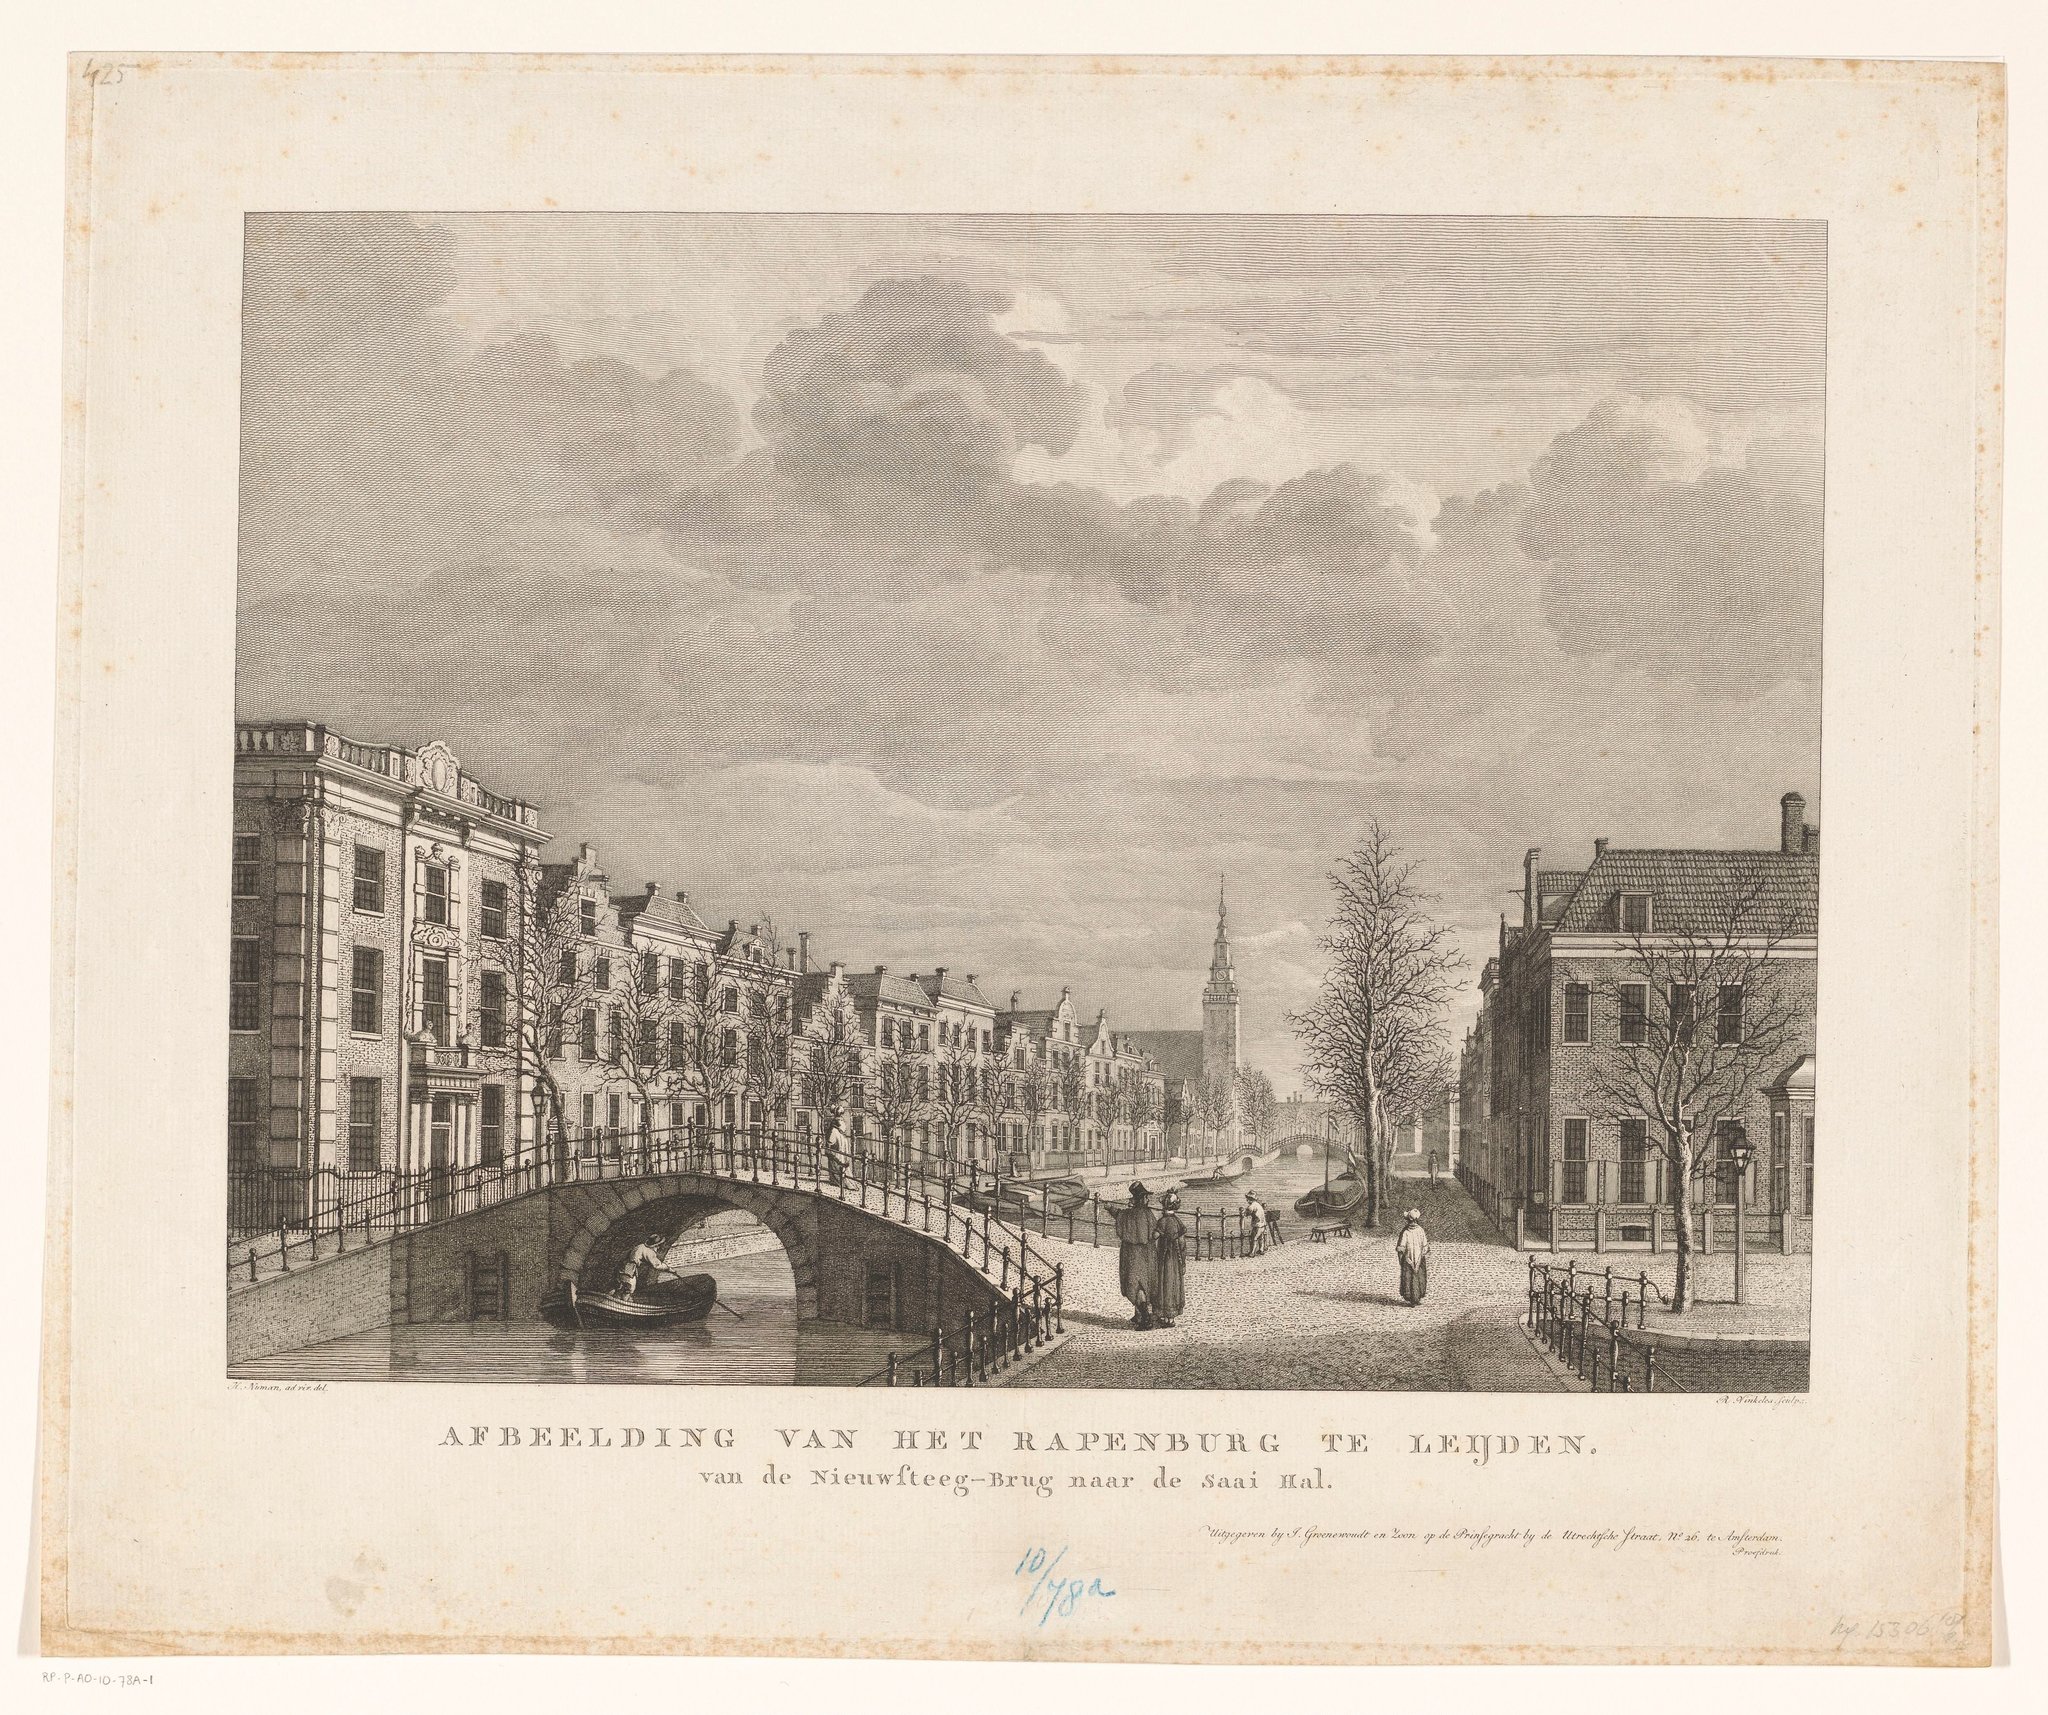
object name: print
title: Gezicht op het Rapenburg te Leiden van de Nieuwsteegbrug, 1807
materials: paper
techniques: engraving, etching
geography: amsterdam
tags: city-view in general; 'veduta'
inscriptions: collector's mark: Lugt 195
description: Gezicht op het het Steenschuur, een gracht in het verlengde van het Rapenburg, te Leiden, in welstand vóór de buskruitramp van 12 januari 1807. Links op de voorgrond de Nieuwsteegbrug met daarachter het Steenschuur. Links op de hoek van het Steenschuur het huis van schepen J.W. van Noort. Op de achtergrond de Saaihal (de latere Sint-Lodewijkskerk).